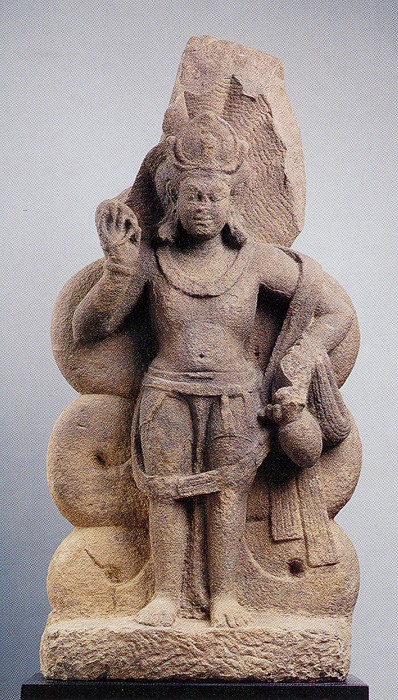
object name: figure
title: Nagaraja (Serpent King)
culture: indian, madhya pradesh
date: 426-450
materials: stone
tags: gupta,kings,hinduism